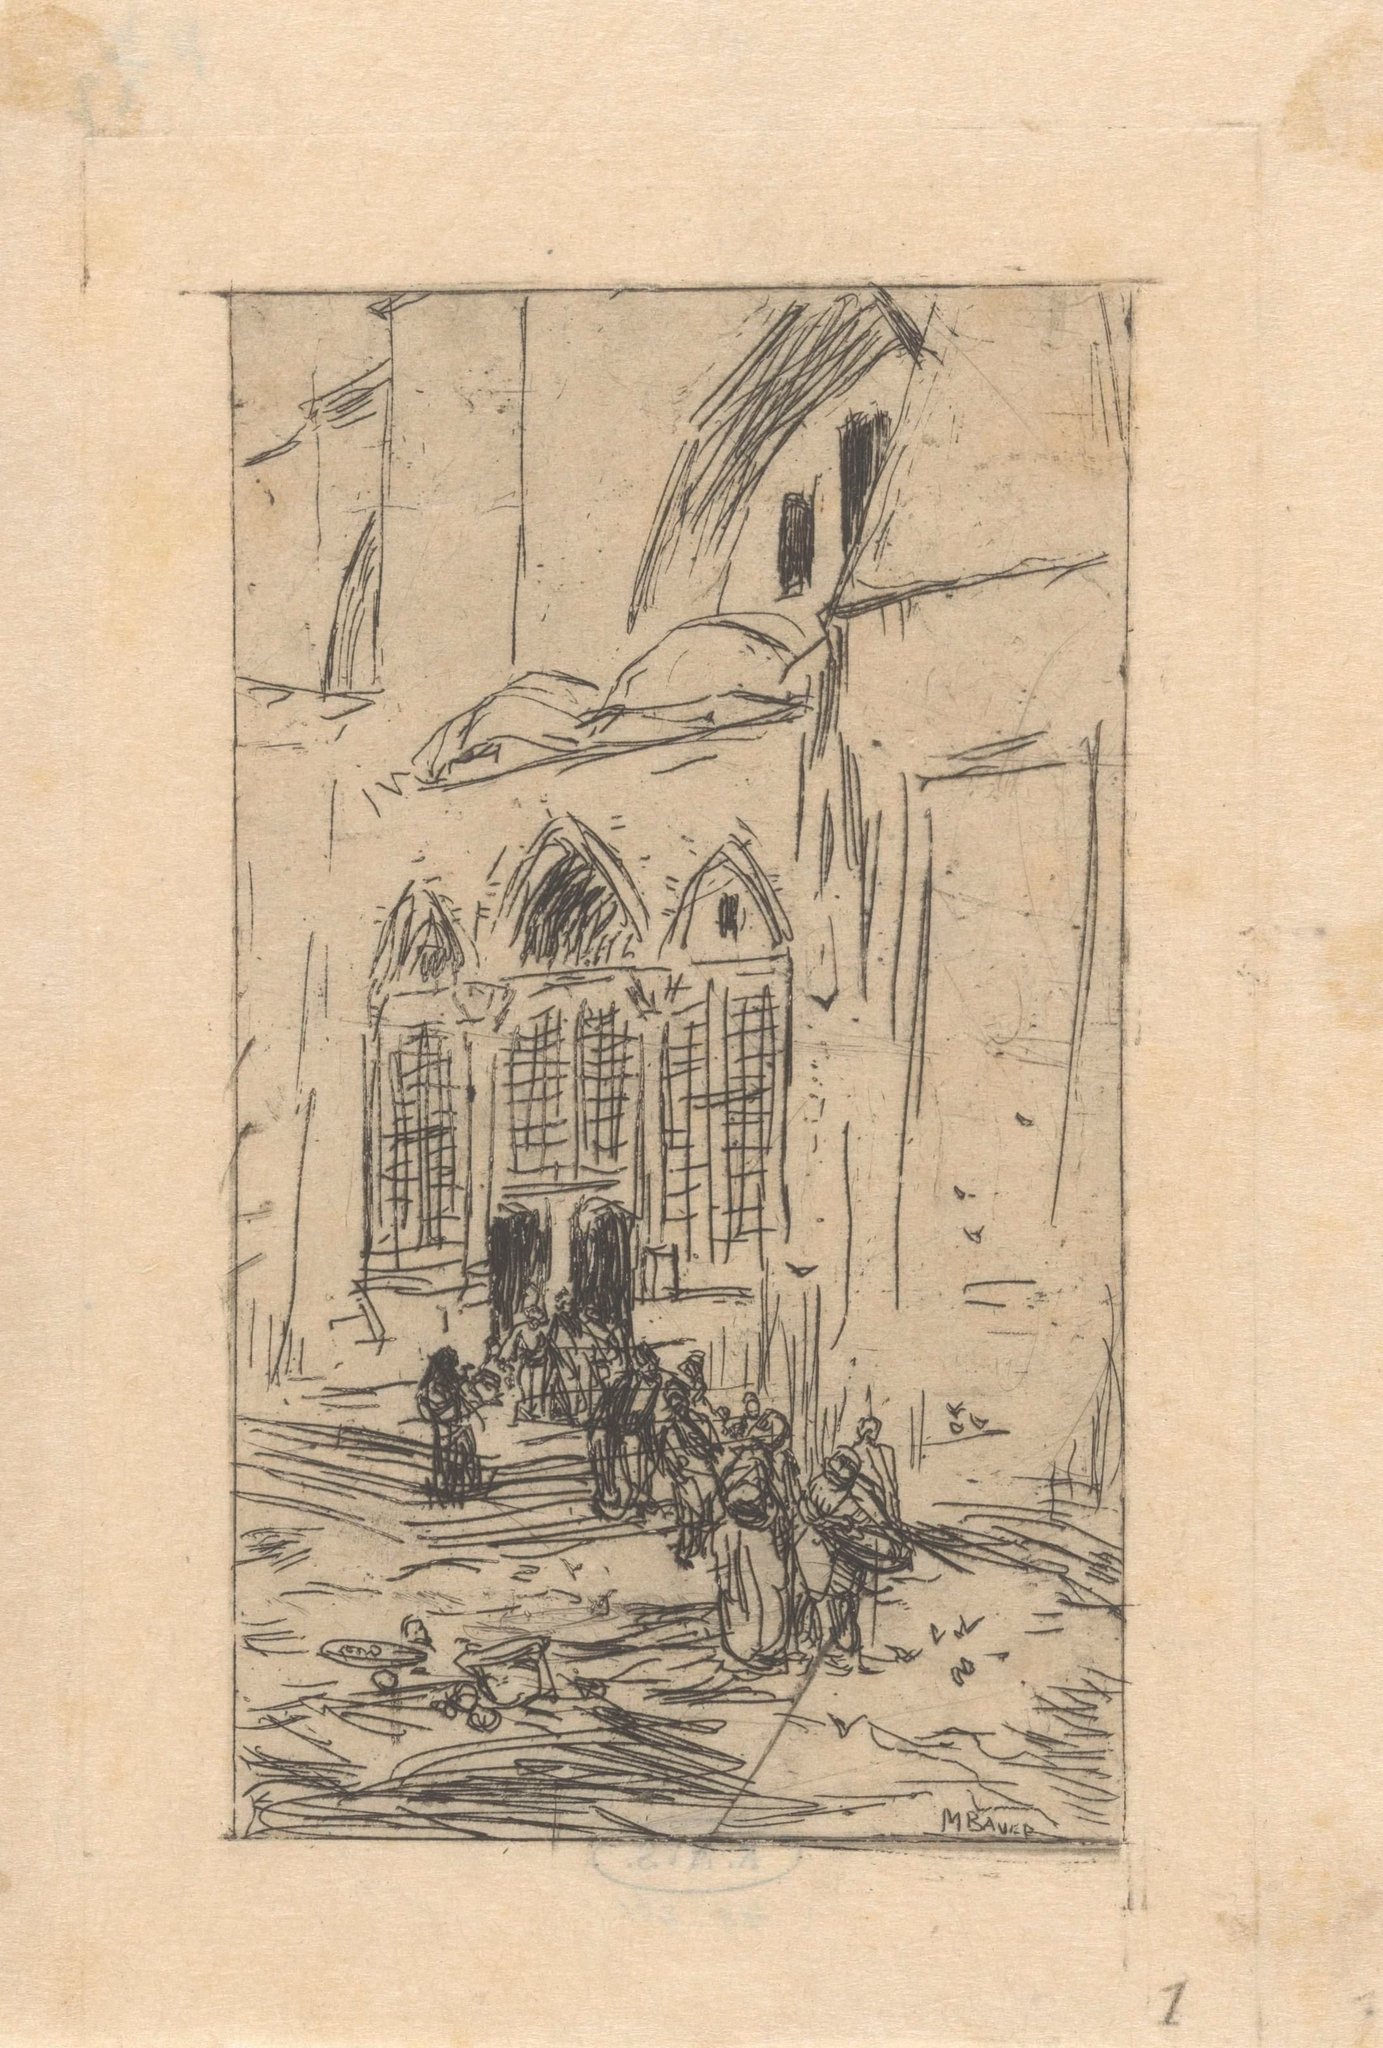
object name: print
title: Süleymaniye-moskee in Constantinopel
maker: marius bauer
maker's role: draughtsman, print maker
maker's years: 1867-1932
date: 1888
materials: paper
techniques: etching, intaglio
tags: temple, shrine ~ islam, mohammedanism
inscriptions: collector's mark: Lugt 2228